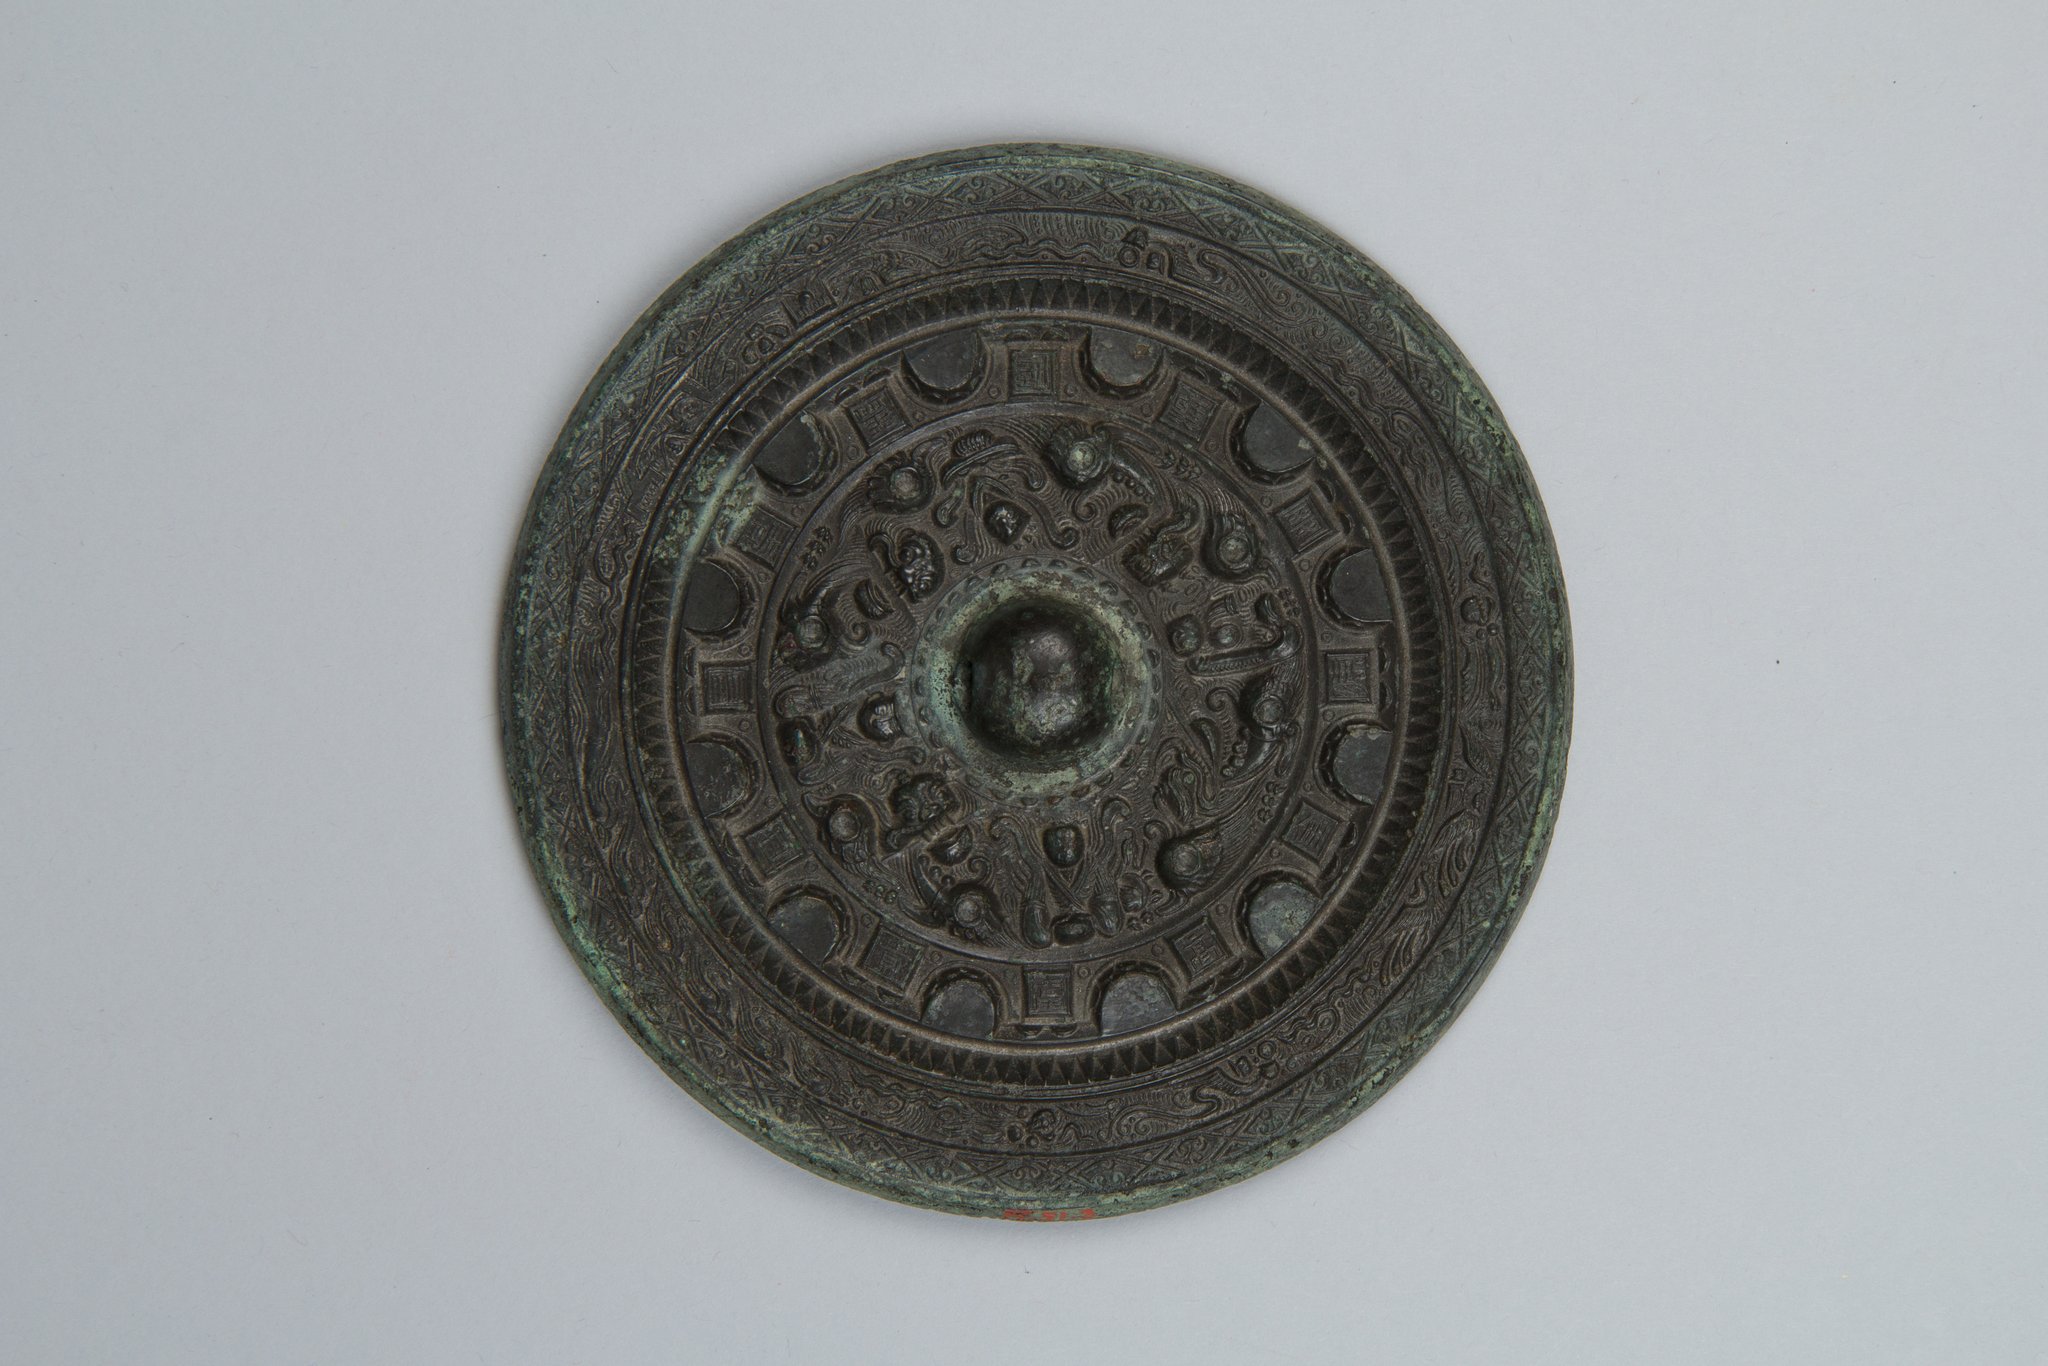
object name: mirror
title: Mirror with deities and mythical creatures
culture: chinese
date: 101-300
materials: bronze